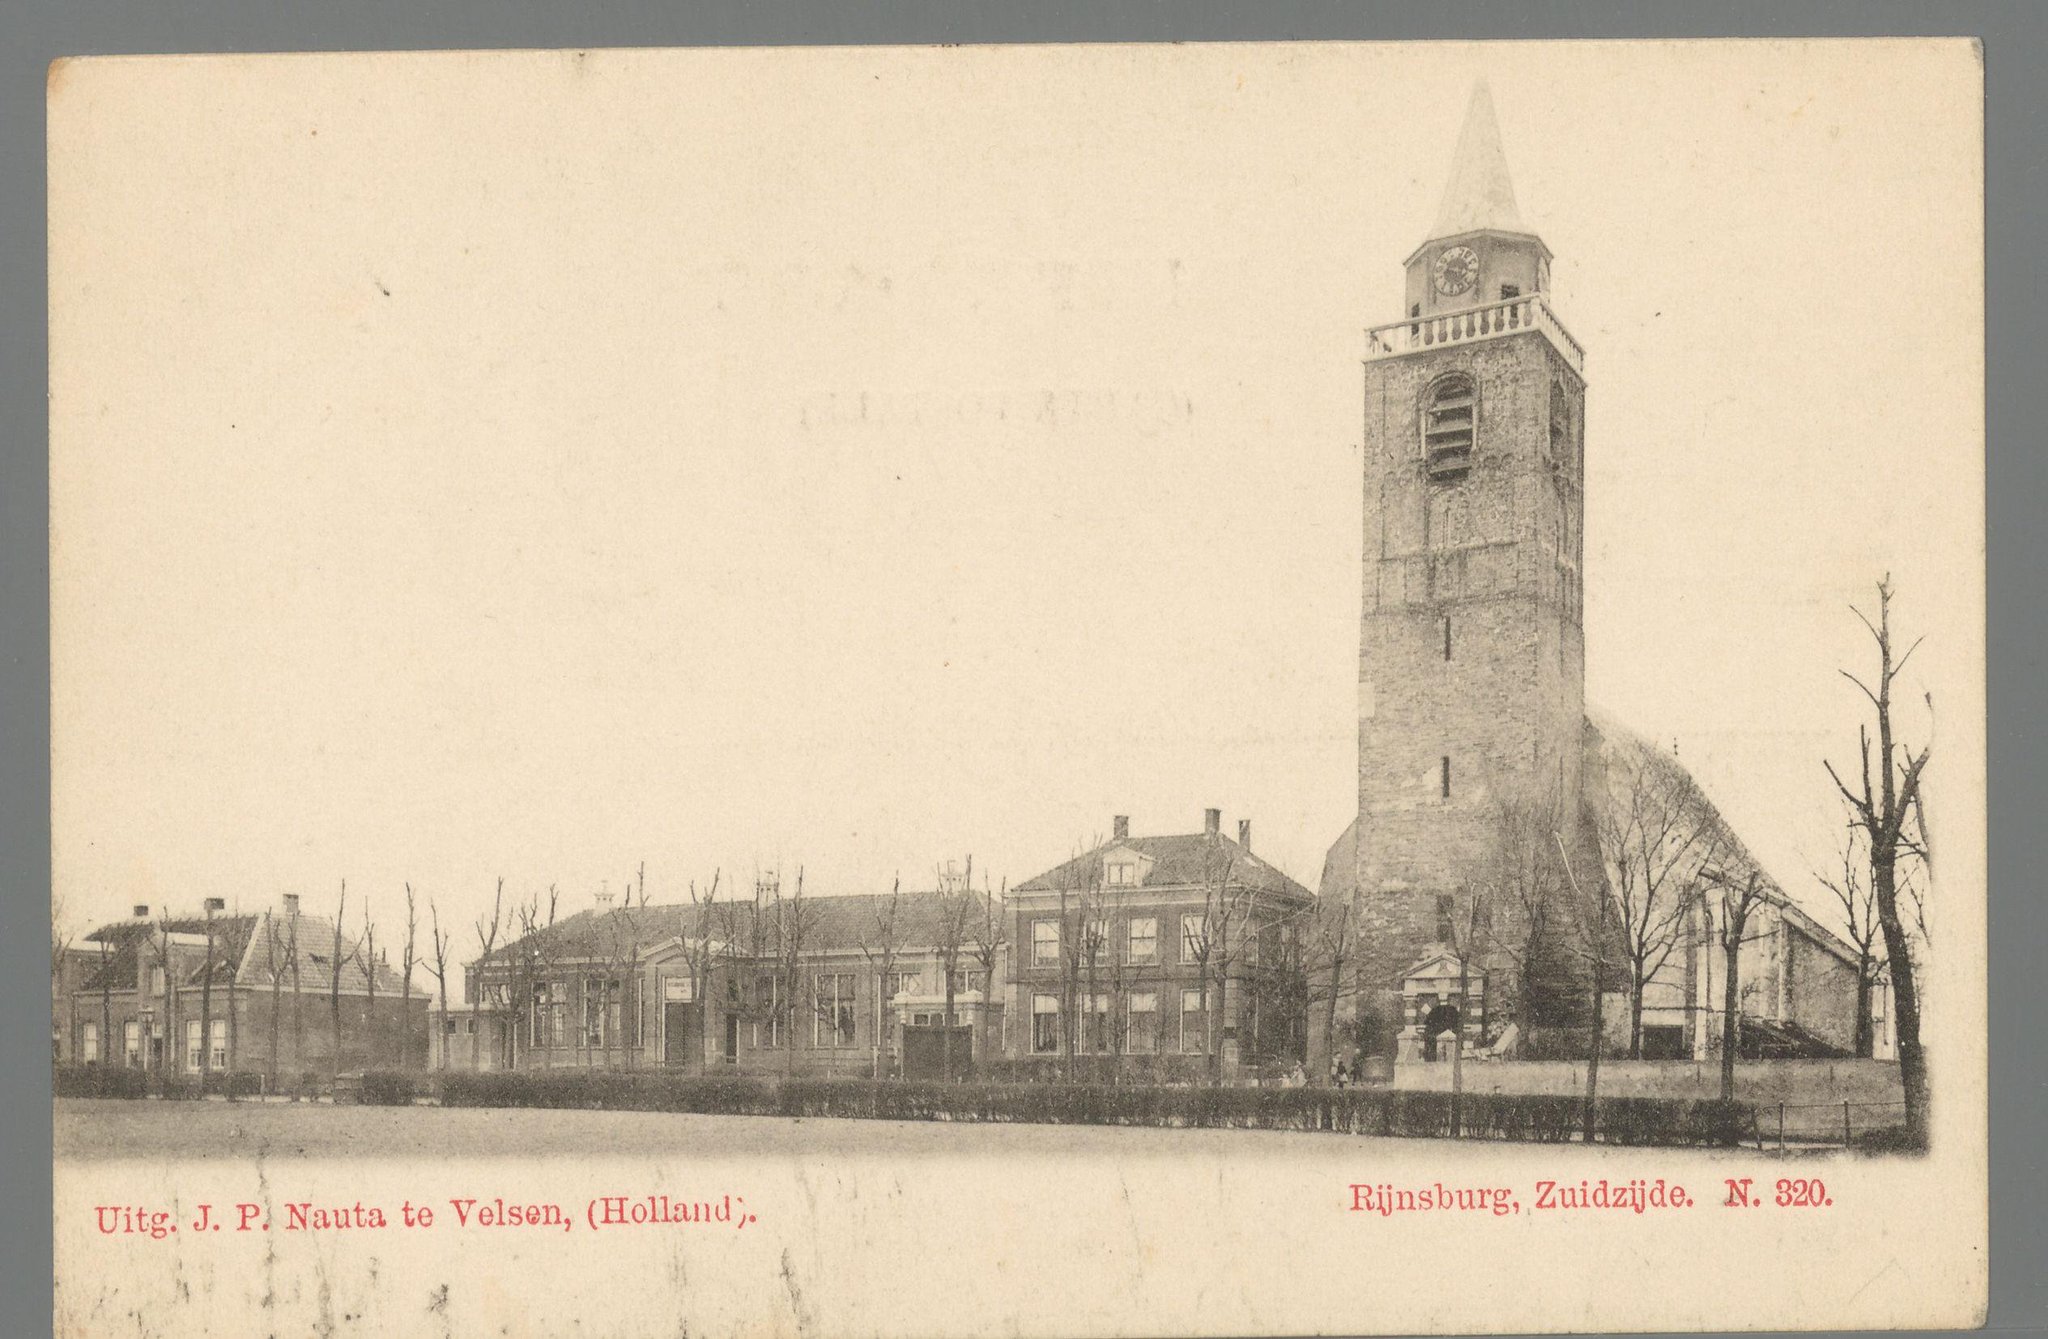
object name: ansichtkaart, prentbriefkaart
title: Rijnsburg, zuidzijde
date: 1897-1905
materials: cardboard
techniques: photograph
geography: velsen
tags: church (exterior), street